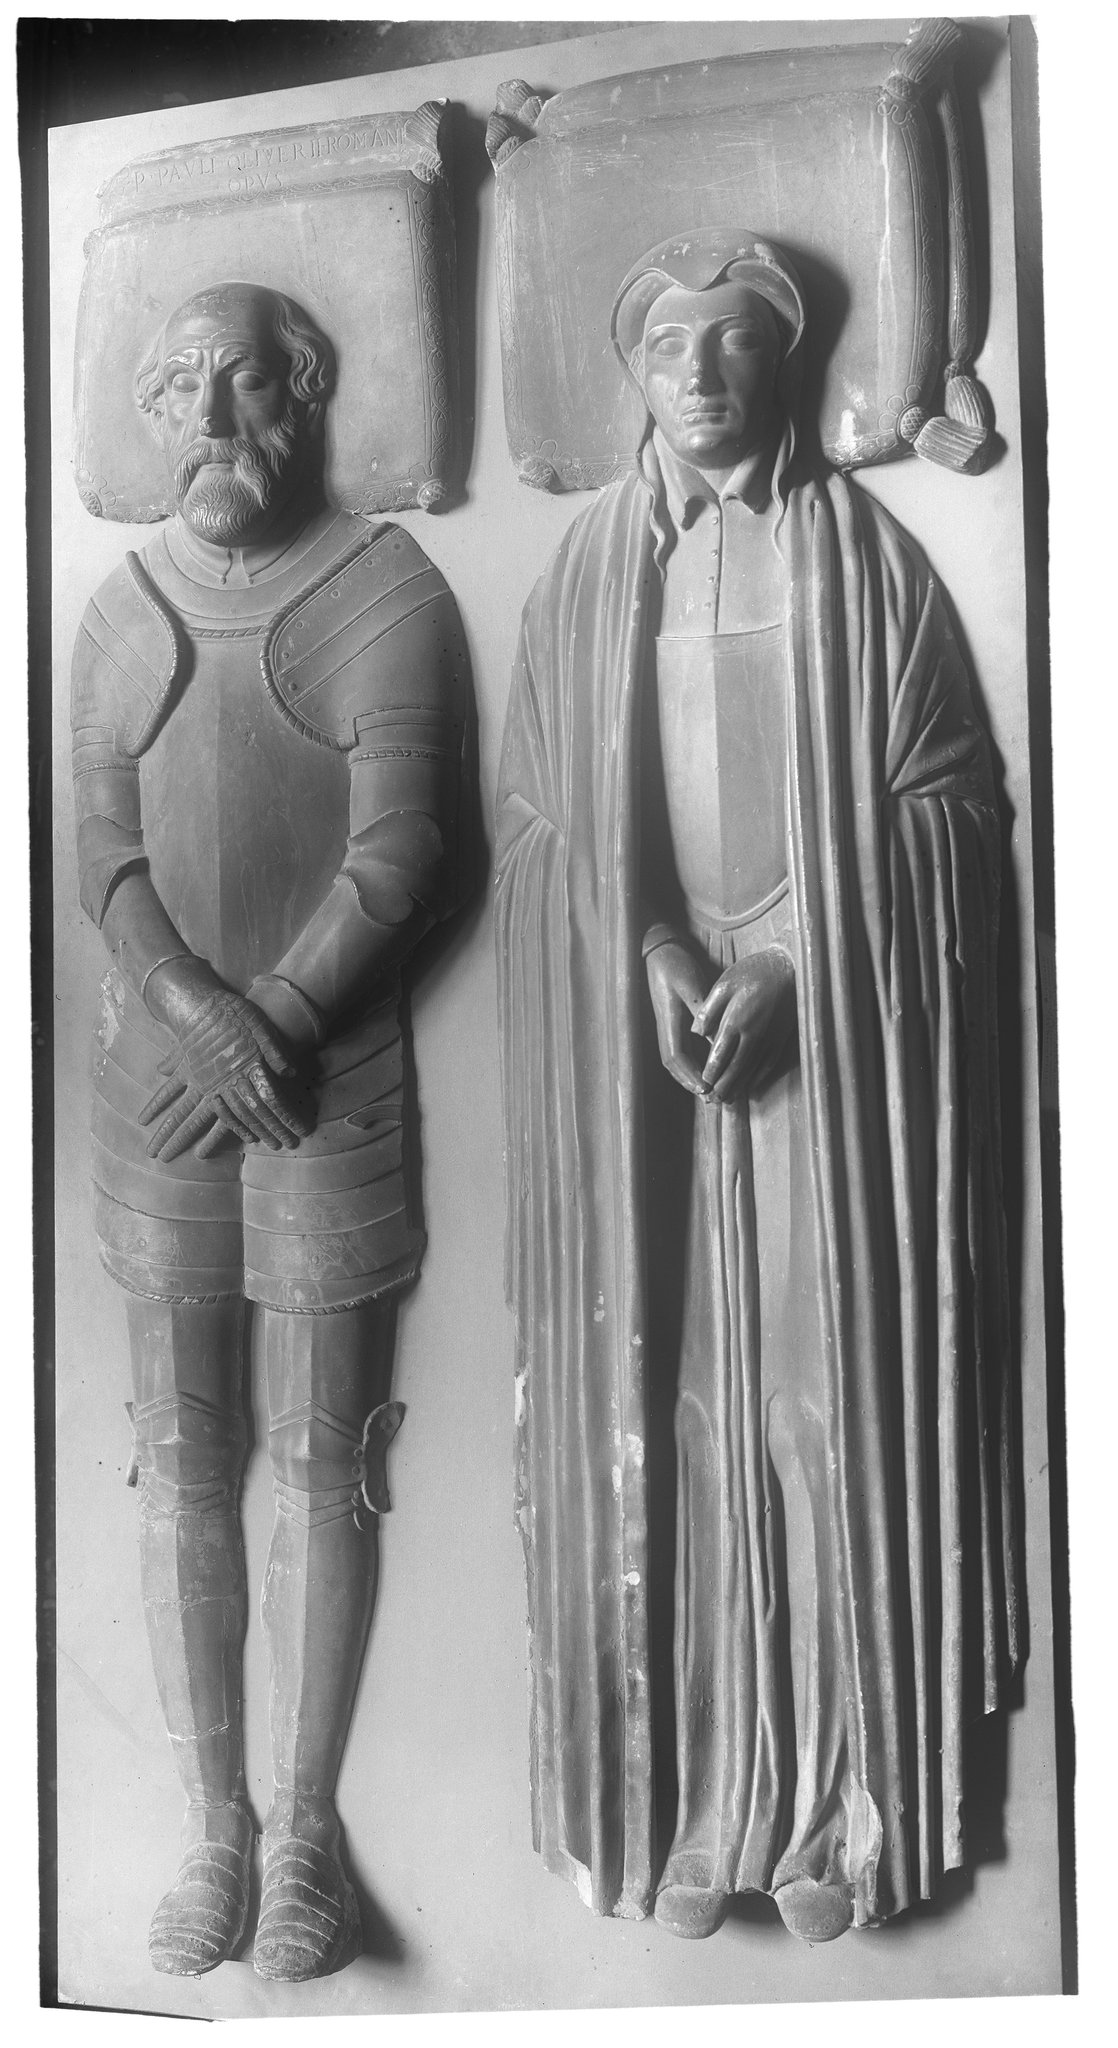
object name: sepulchral effigy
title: A man in armor and his wife in a long cloak (possibly Huguenots)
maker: pietro paolo olivieri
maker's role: artist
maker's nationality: italian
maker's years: 1551-1599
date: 1501-1600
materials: marble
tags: men,women